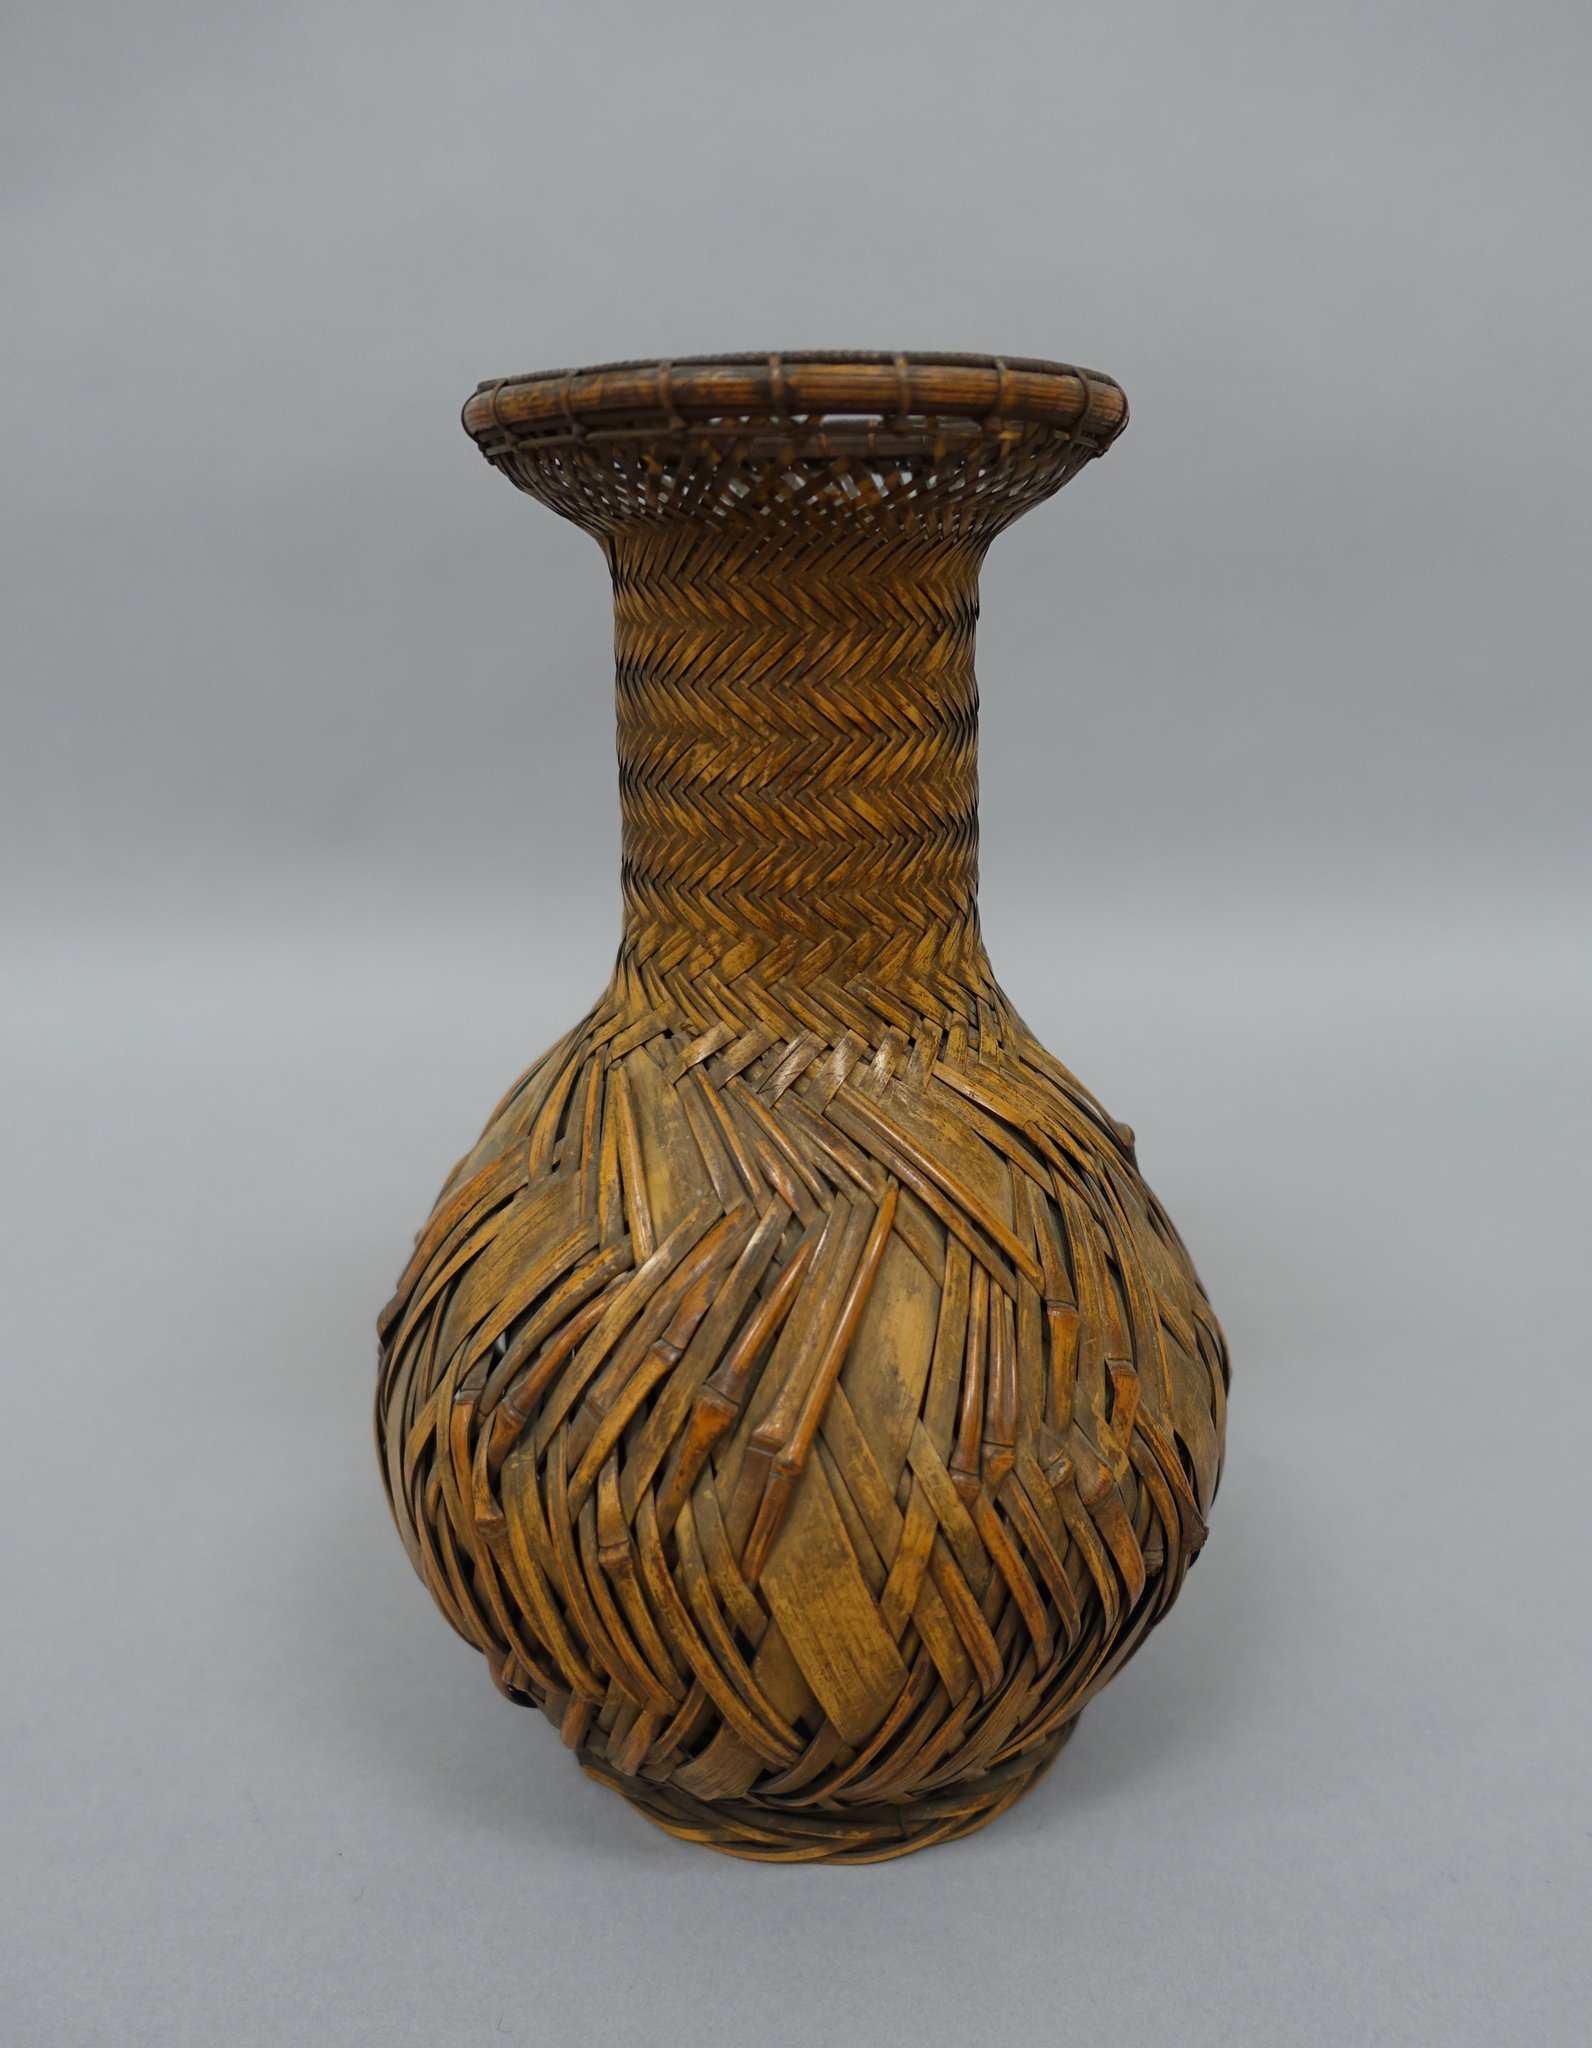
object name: basket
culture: japanese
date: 1801-1900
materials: bamboo